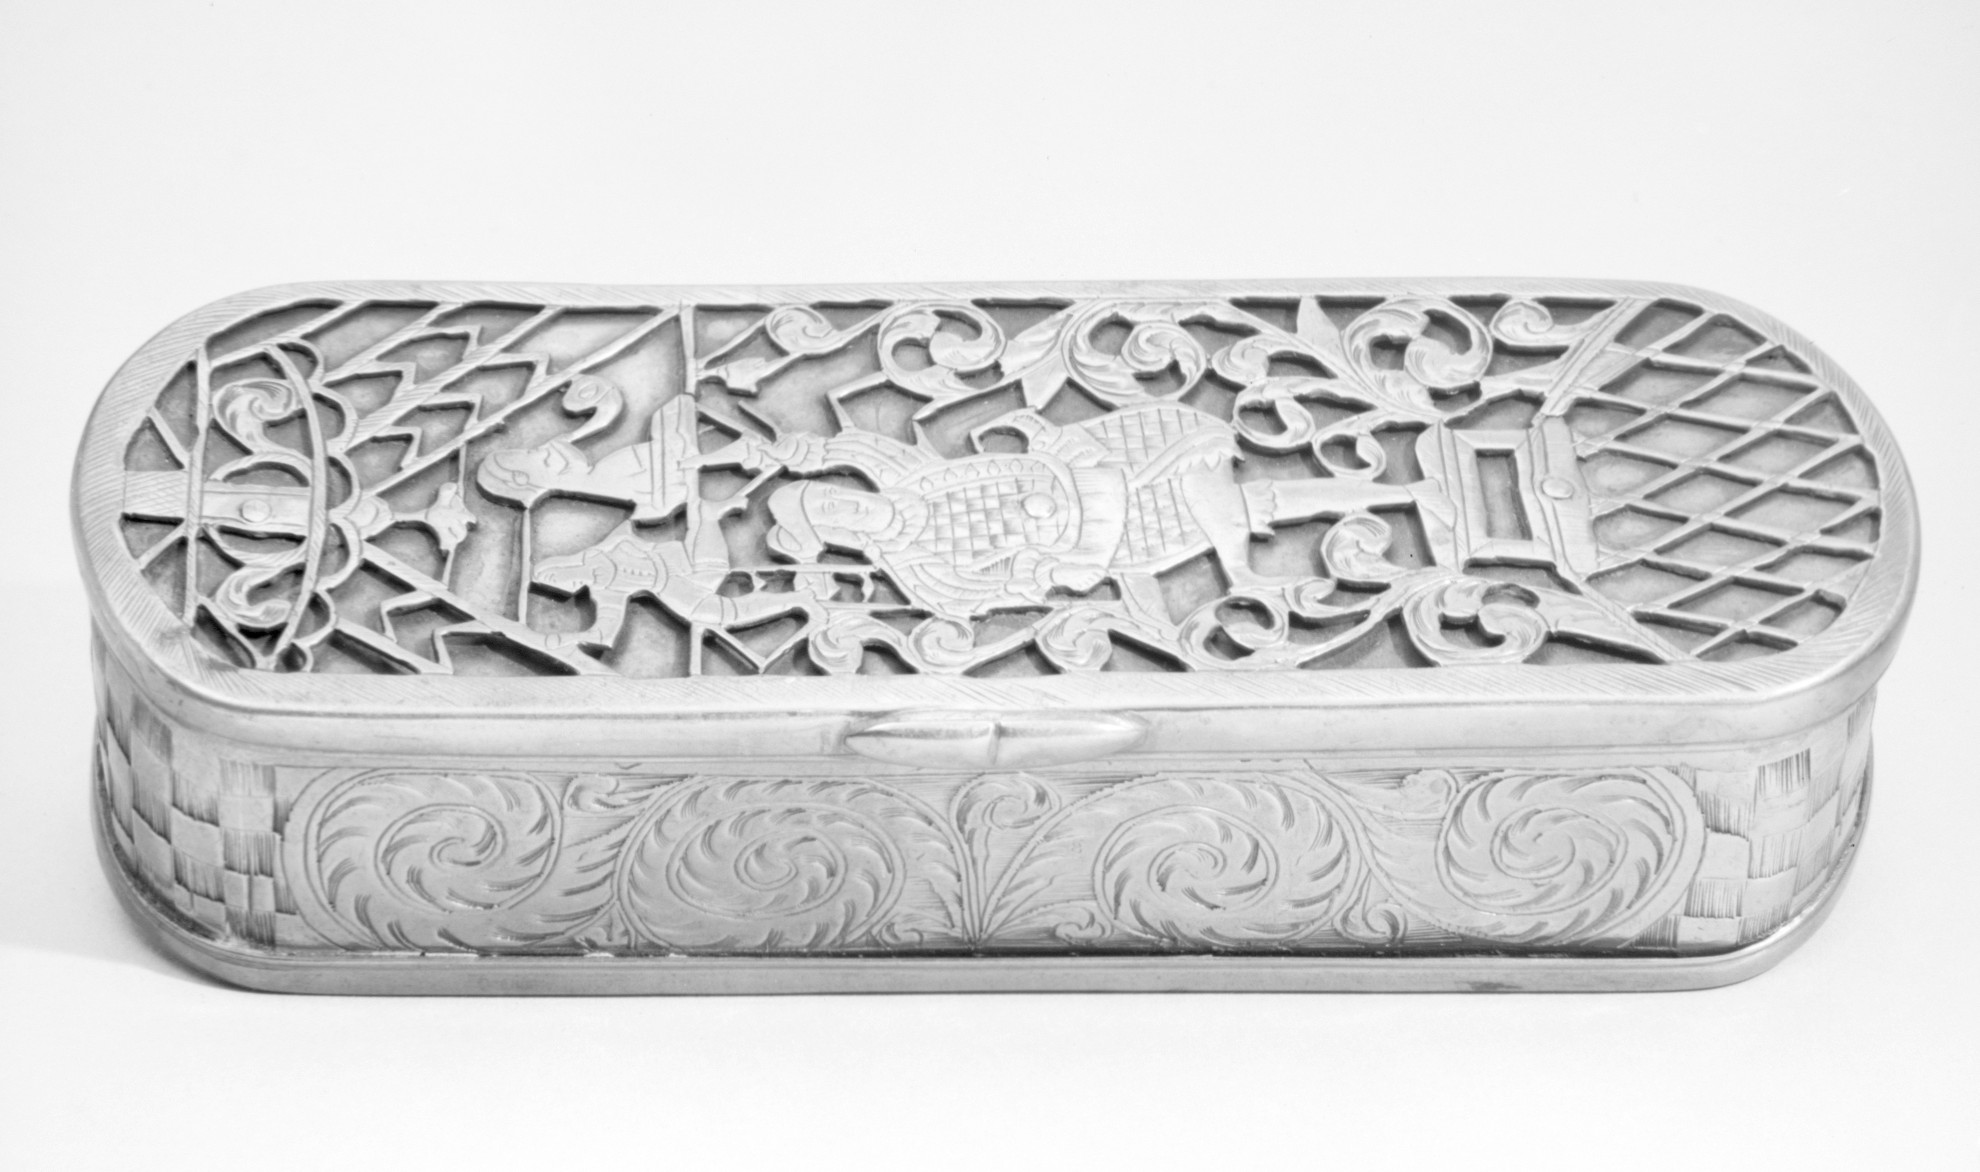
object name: tobacco box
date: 1781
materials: brass, copper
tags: men